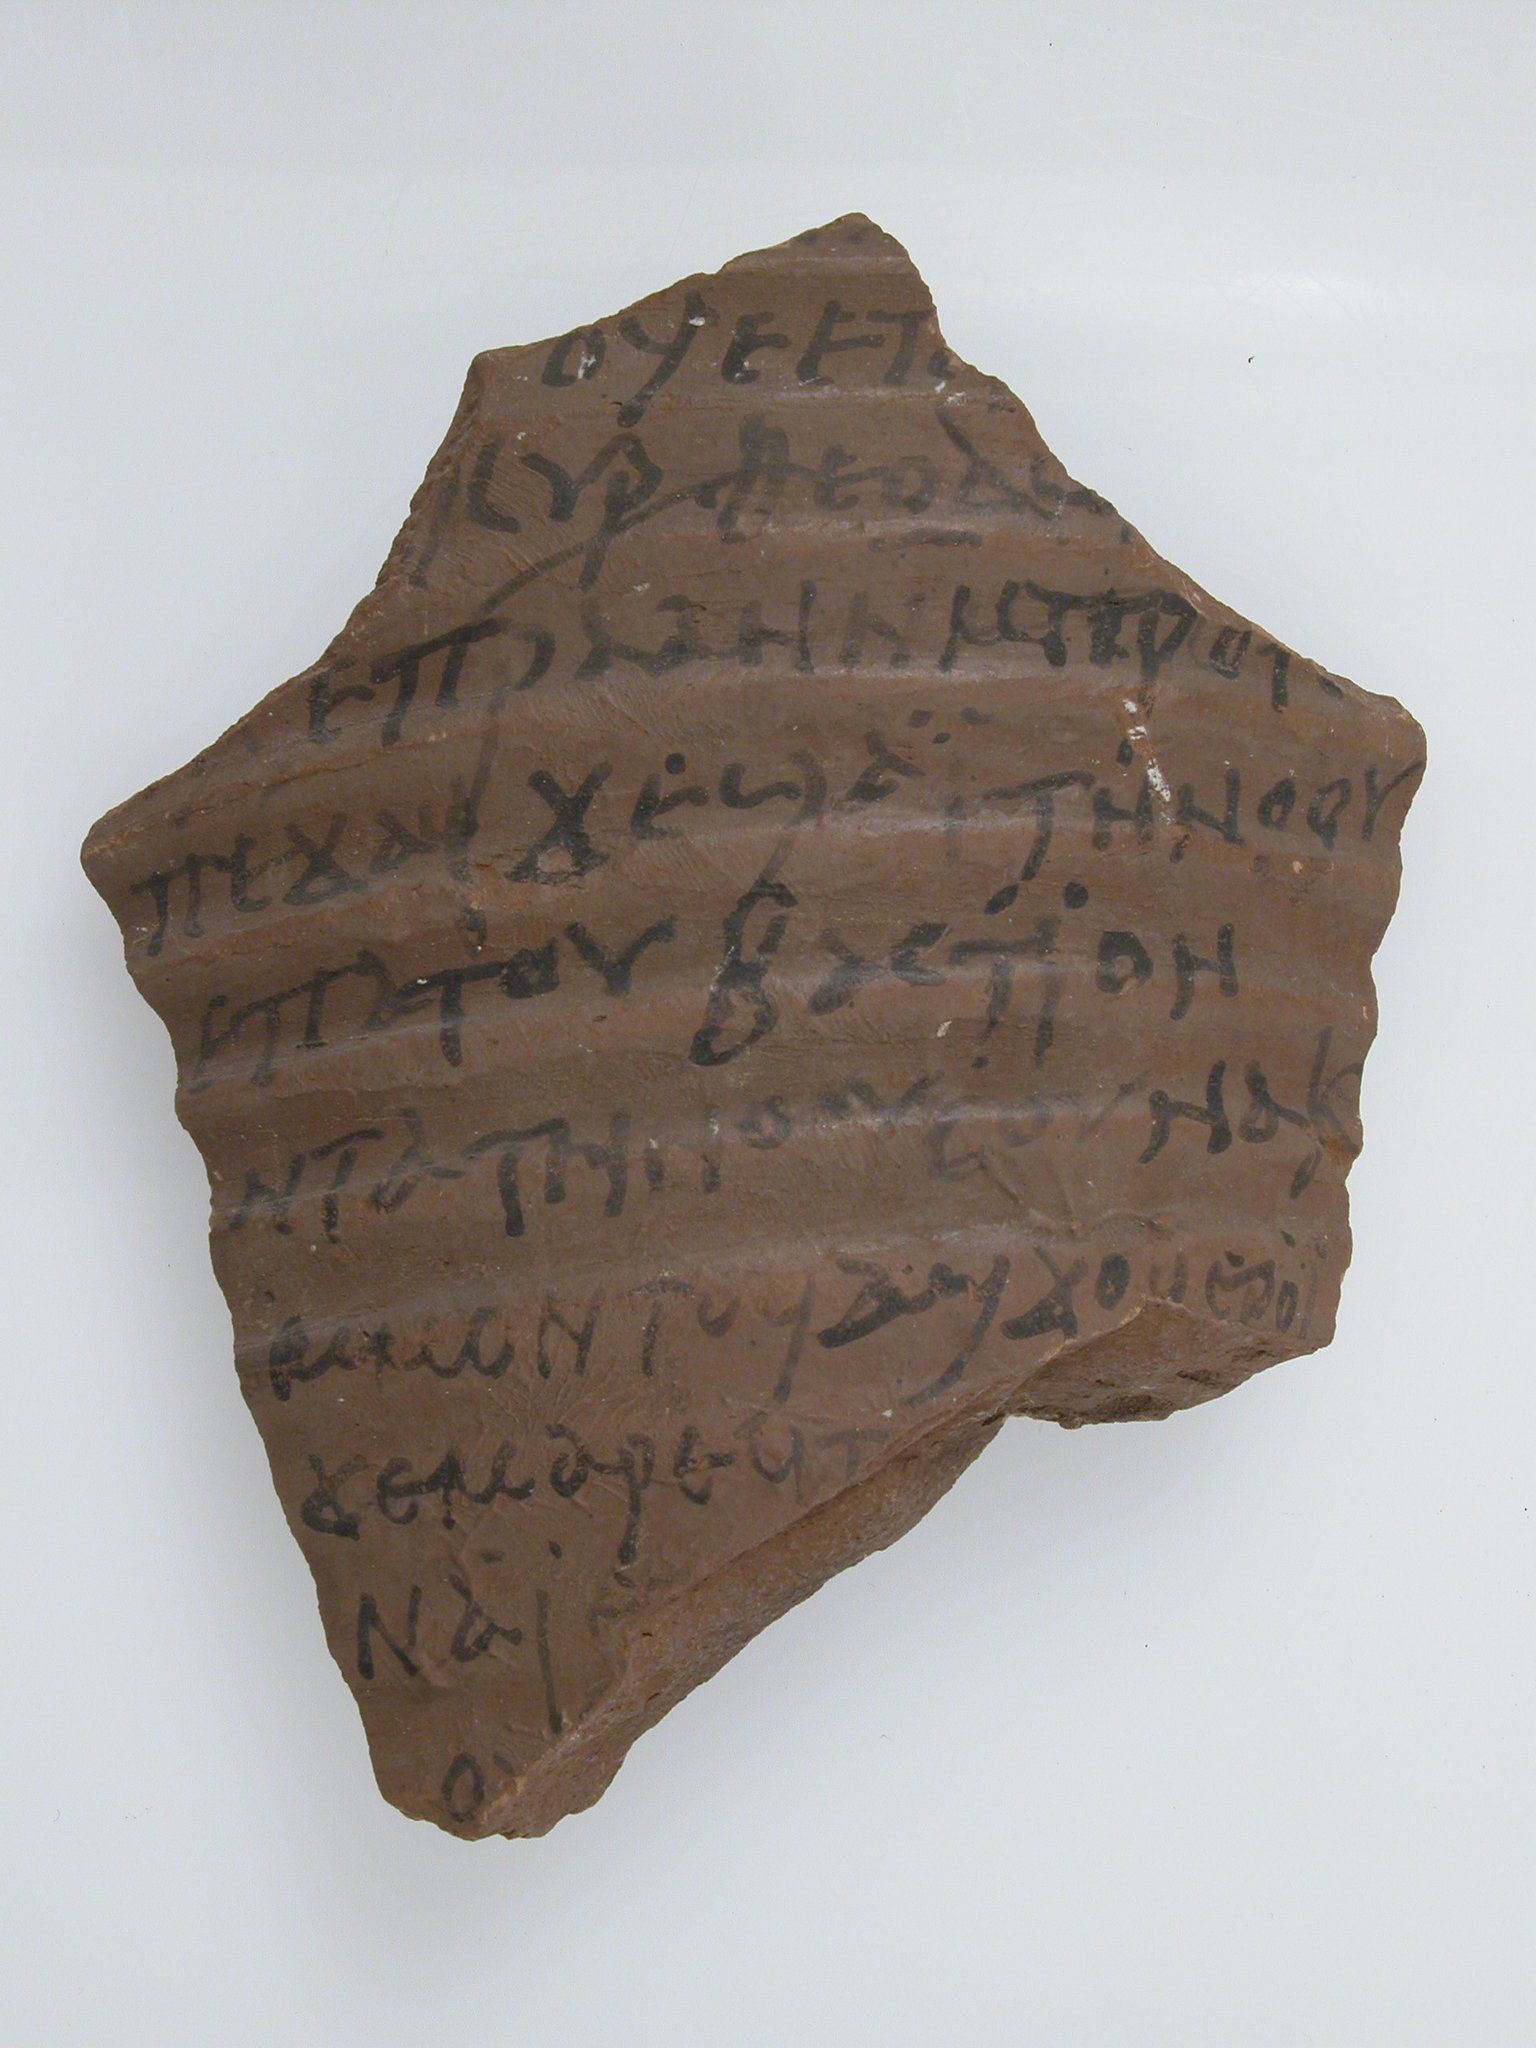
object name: ostrakon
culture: coptic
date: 601-700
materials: ink, pottery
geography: egypt